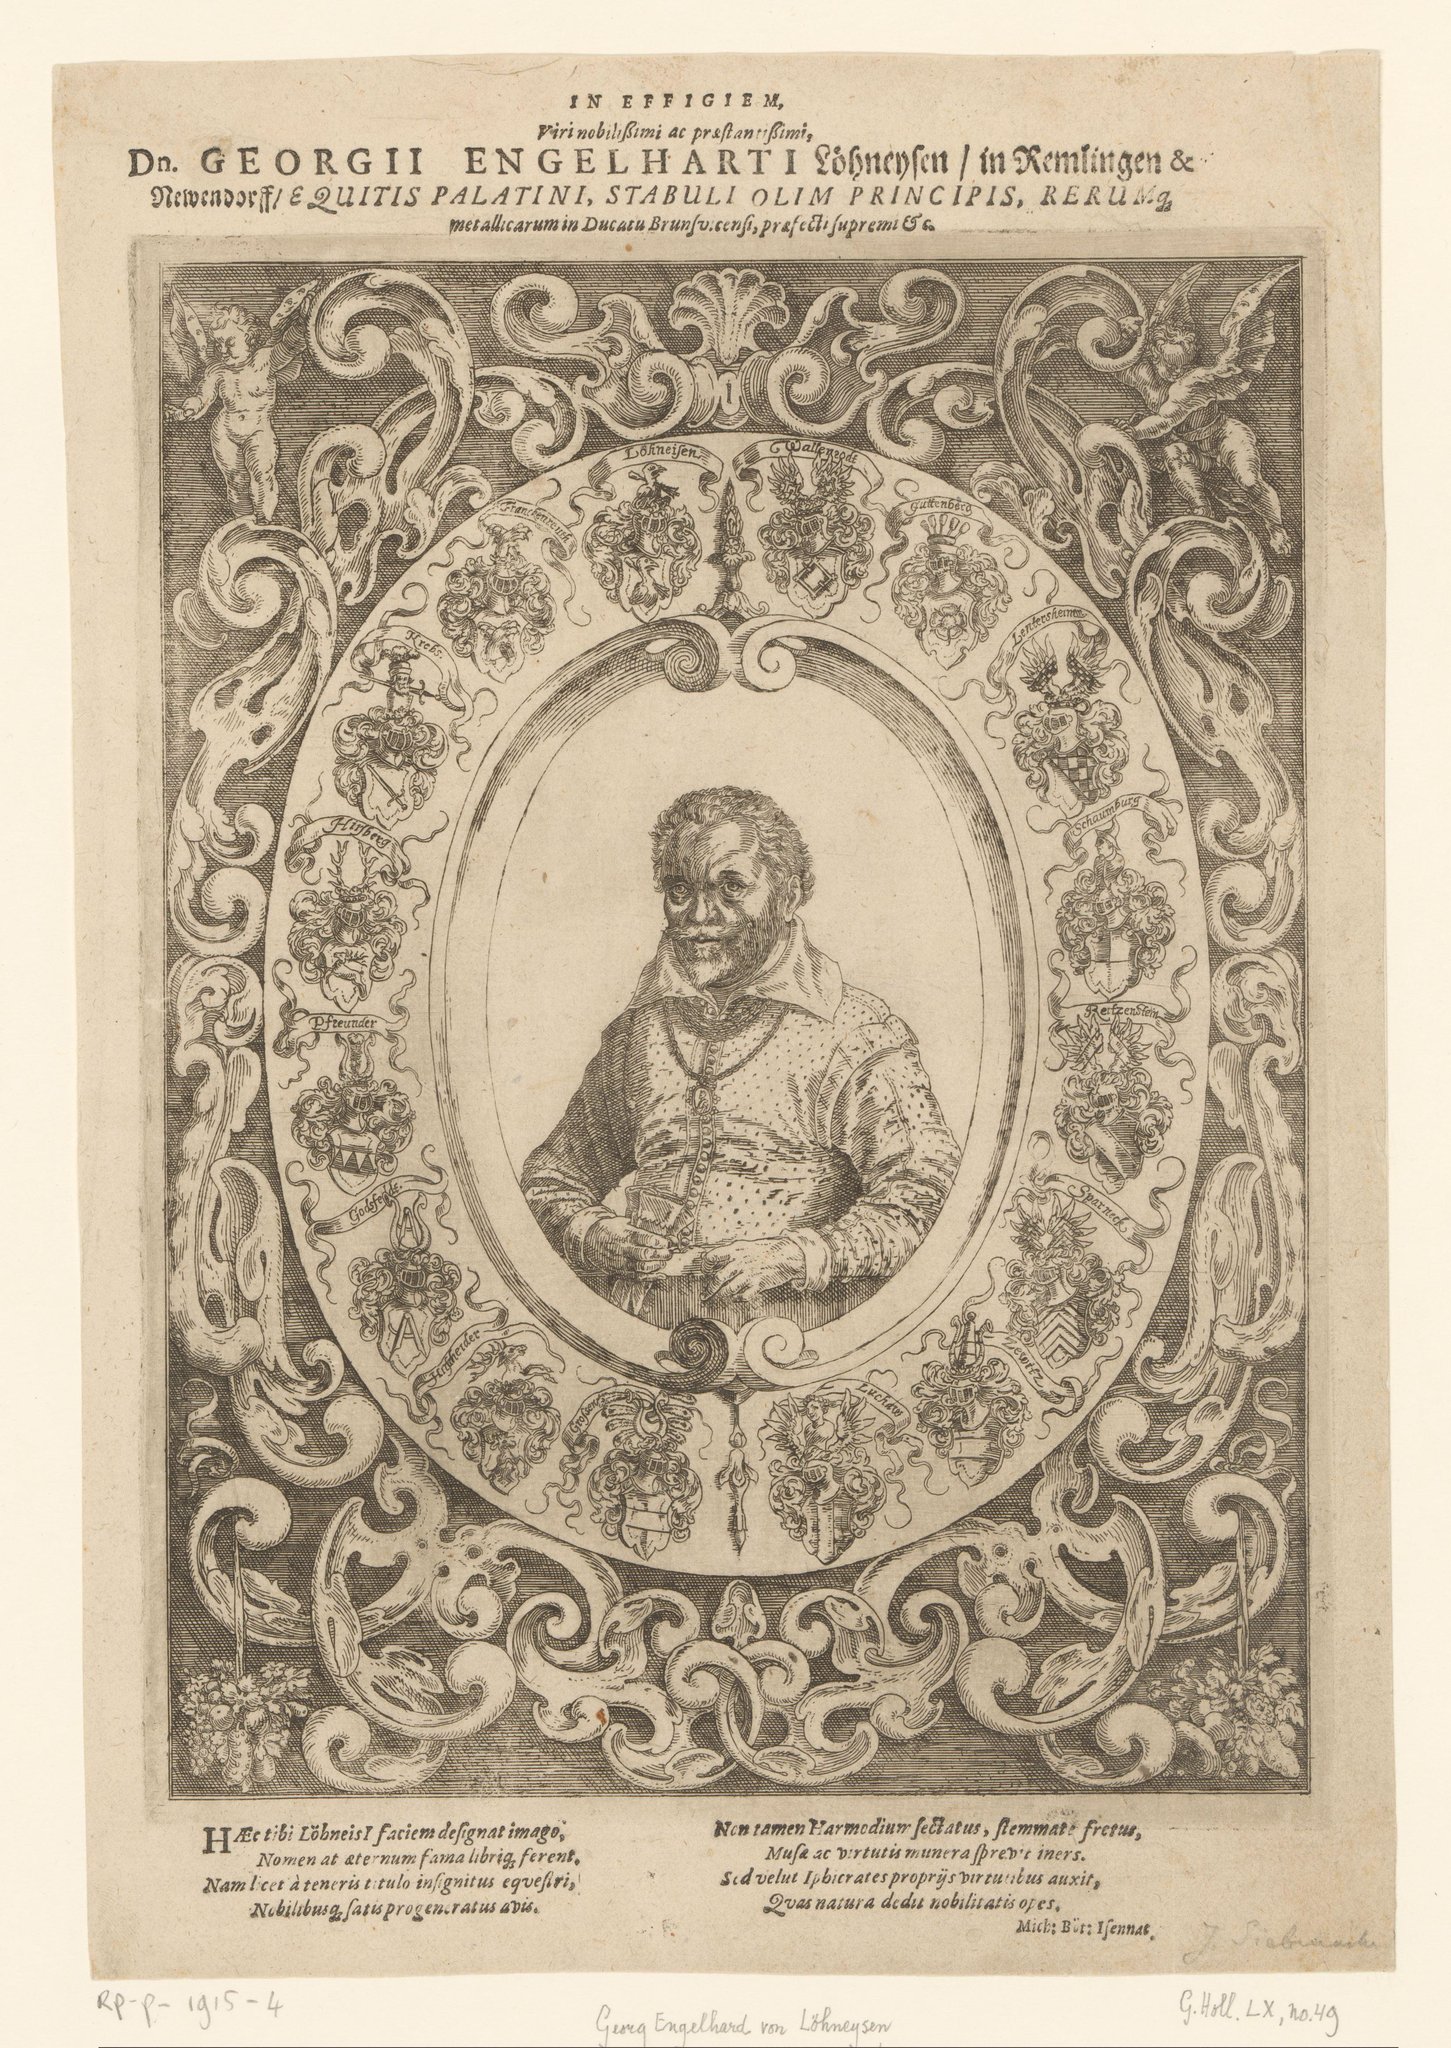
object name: print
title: Portret van Georg Engelhard Löhneysen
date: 1590-1611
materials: paper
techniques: etching, letterpress printing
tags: gloves, mittens, etc., historical persons, pendant, trinket, 'breloque', armorial bearing, heraldry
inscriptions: collector's mark: Lugt 2228